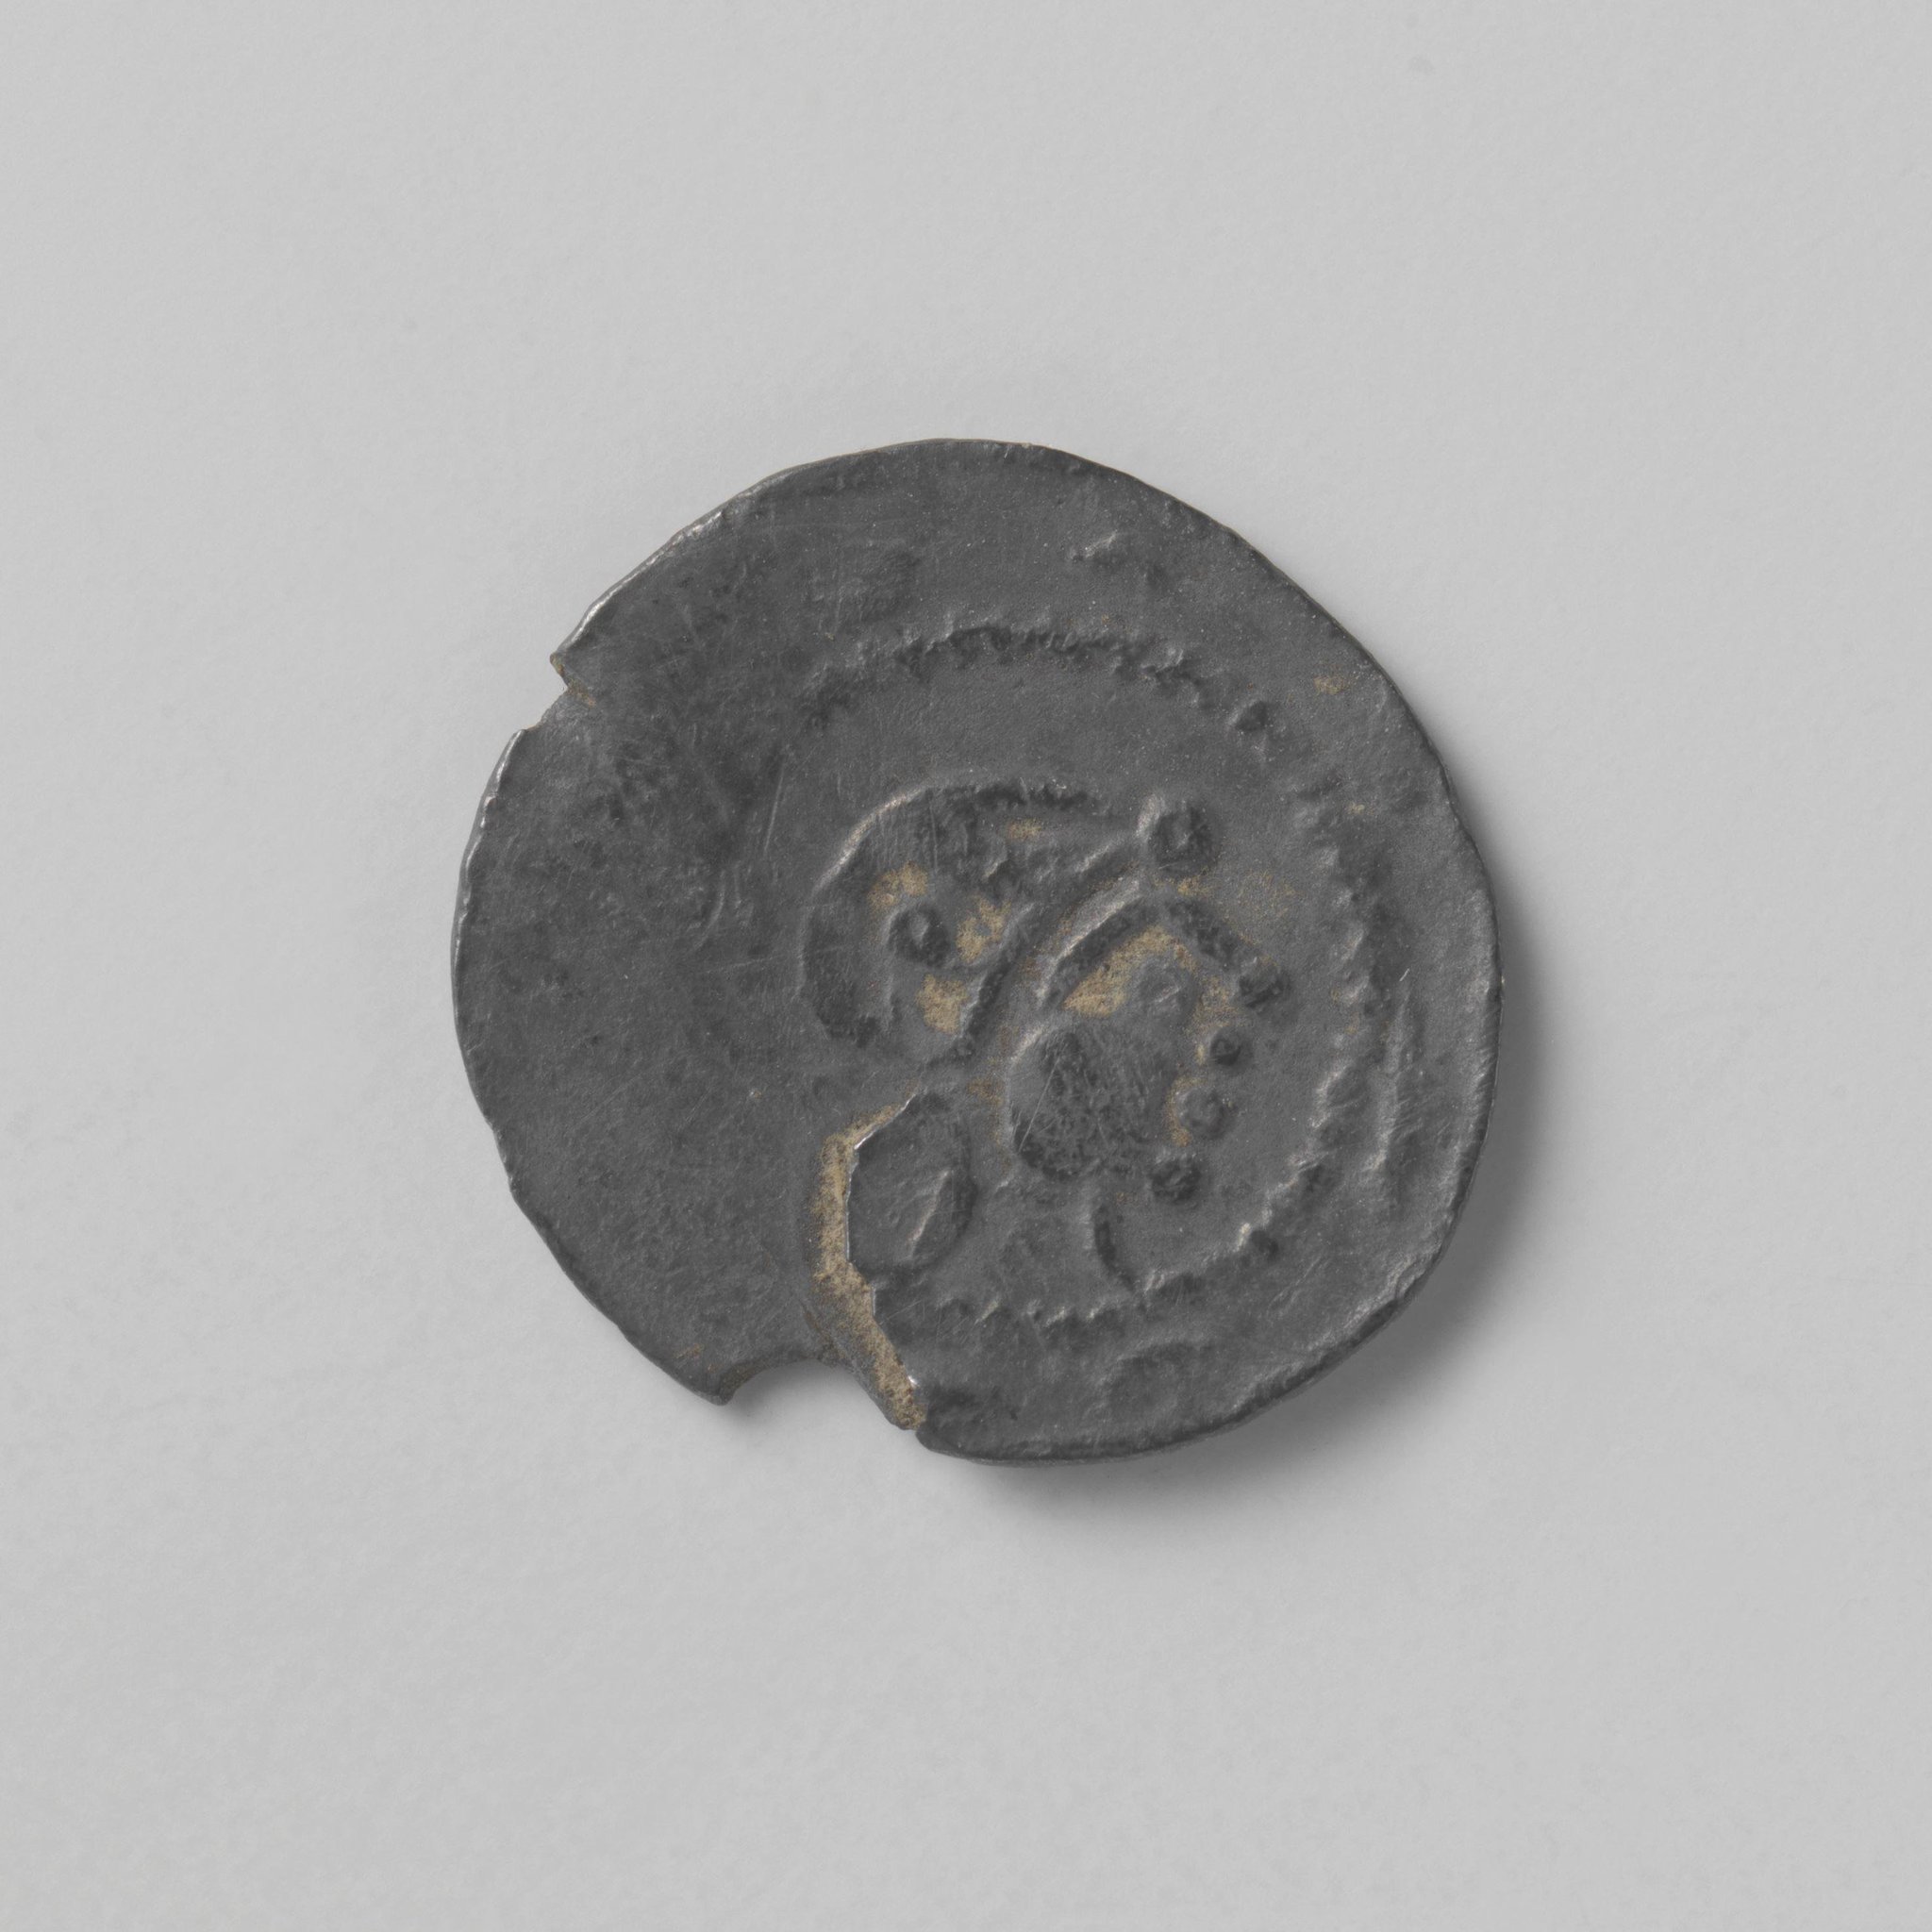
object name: penny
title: Hollandse penning van Floris V, 1256-1296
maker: floris v (graaf van holland en zeeland)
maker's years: 1254-1296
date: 1256-1258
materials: silver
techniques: striking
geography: dordrecht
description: Zilveren munt. Voorzijde: hoofd met gravenmuts naar rechts. Keerzijde: lang dubbellijnig kruis.